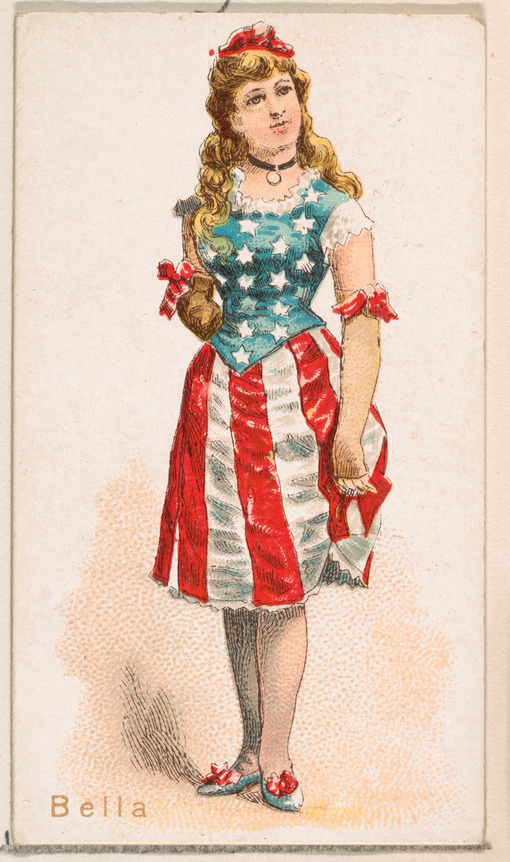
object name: print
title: Bella, from the Ballet Queens series (N182) issued by Wm. S. Kimball & Co.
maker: william s. kimball & company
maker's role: publisher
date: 1889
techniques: color lithograph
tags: women